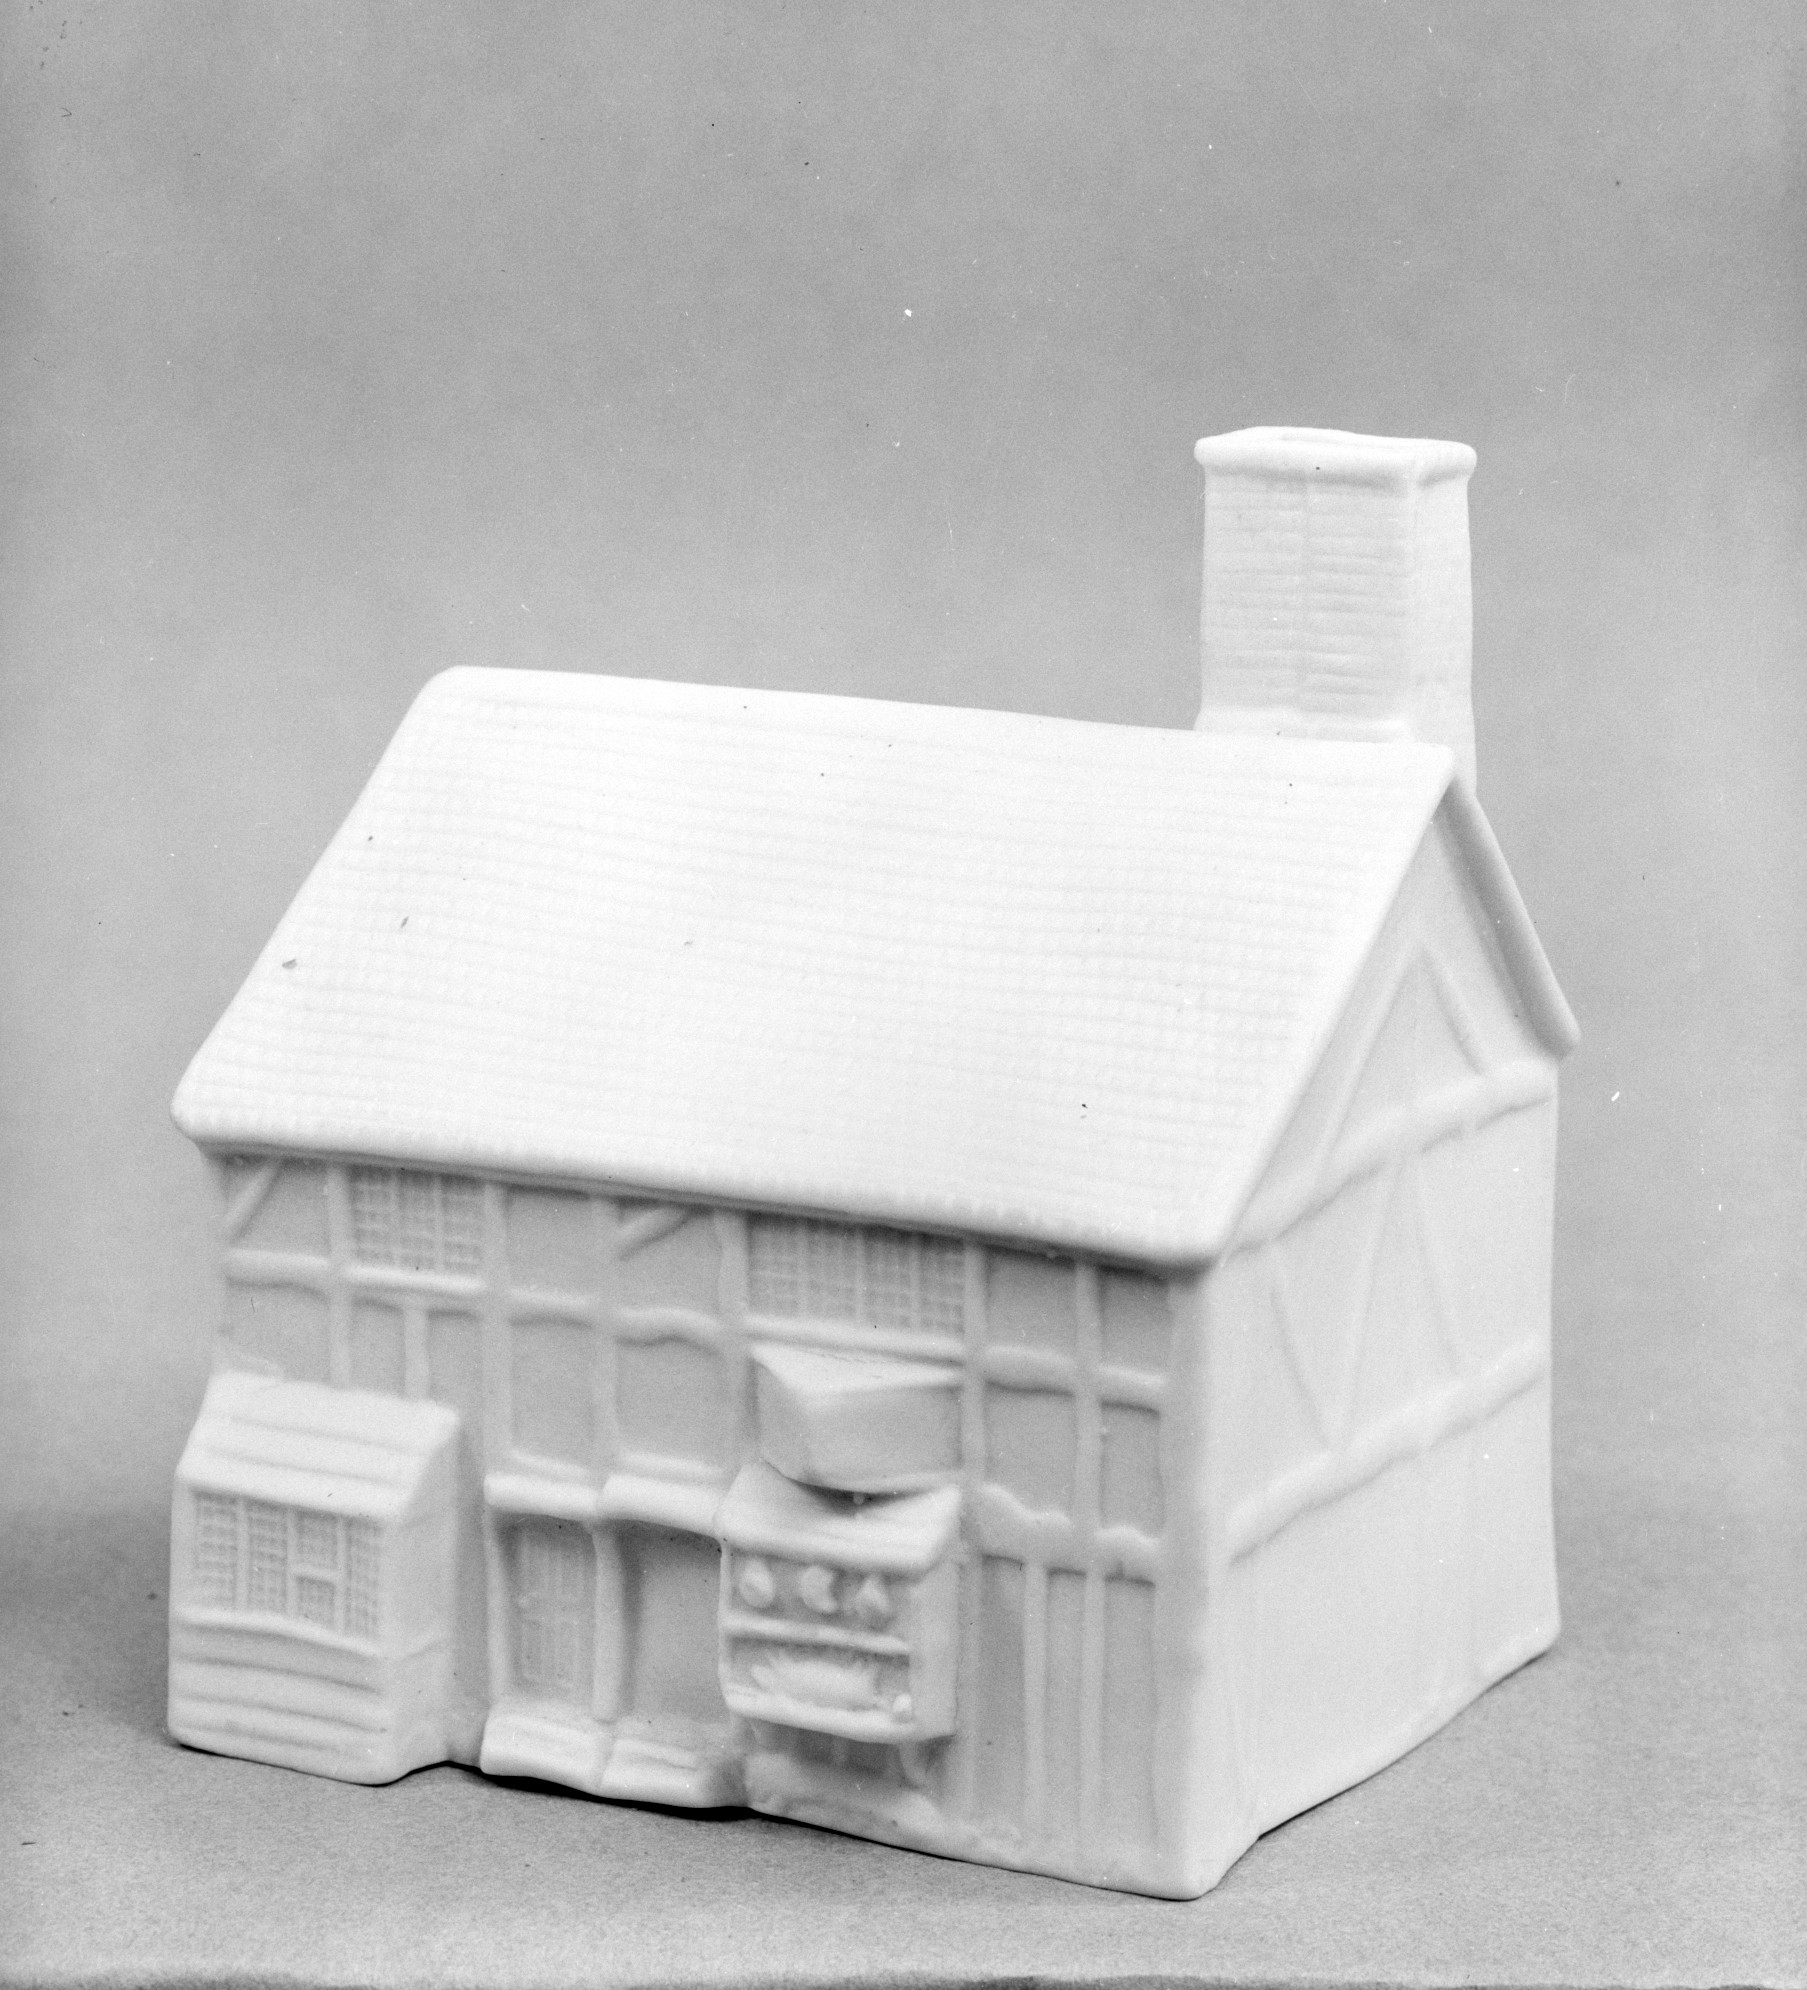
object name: figure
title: Figure of William Shakespeare's Birthplace in Stratford-on-Avon, England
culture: american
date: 1830-1870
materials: porcelain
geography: united states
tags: houses